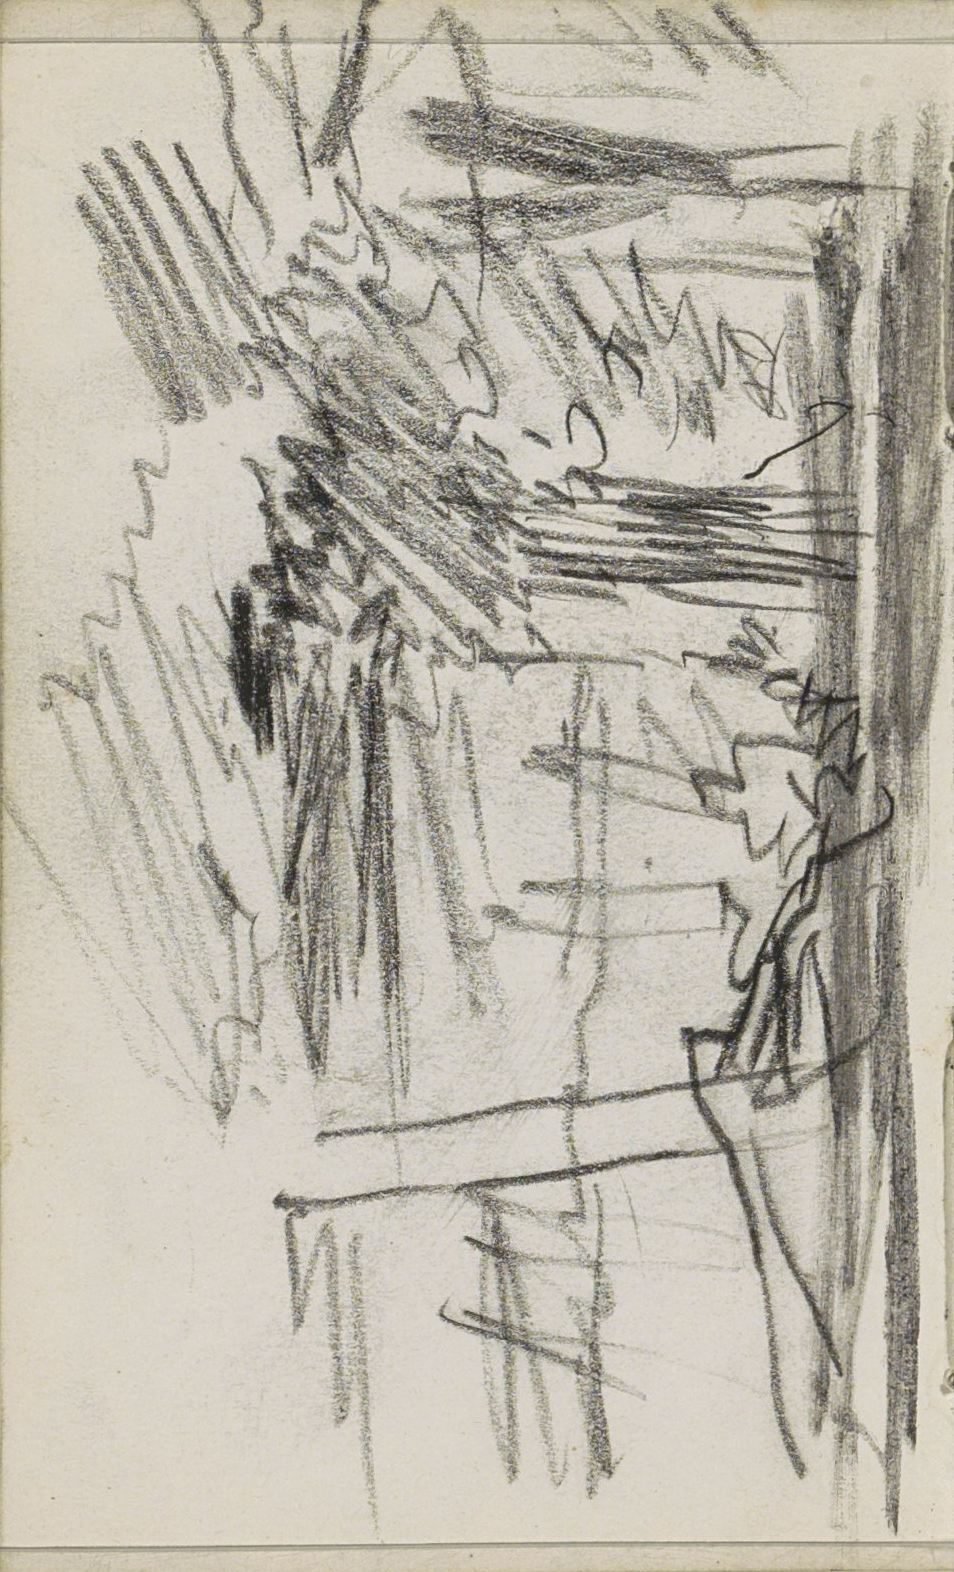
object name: sketchbook leaf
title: Studie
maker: anton mauve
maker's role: draughtsman, painter, print maker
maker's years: 1838-1888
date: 1848-1888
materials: chalk, paper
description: Blad 35 verso uit een schetsboek met 53 bladen.